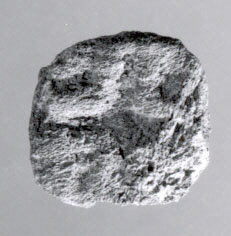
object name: stamp seal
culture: bactria-margiana archaeological complex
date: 2333-1668 BCE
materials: copper alloy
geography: bactria-margiana